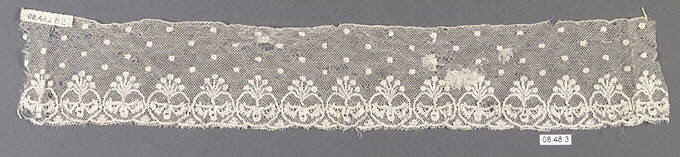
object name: edging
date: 1801-1900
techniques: lace